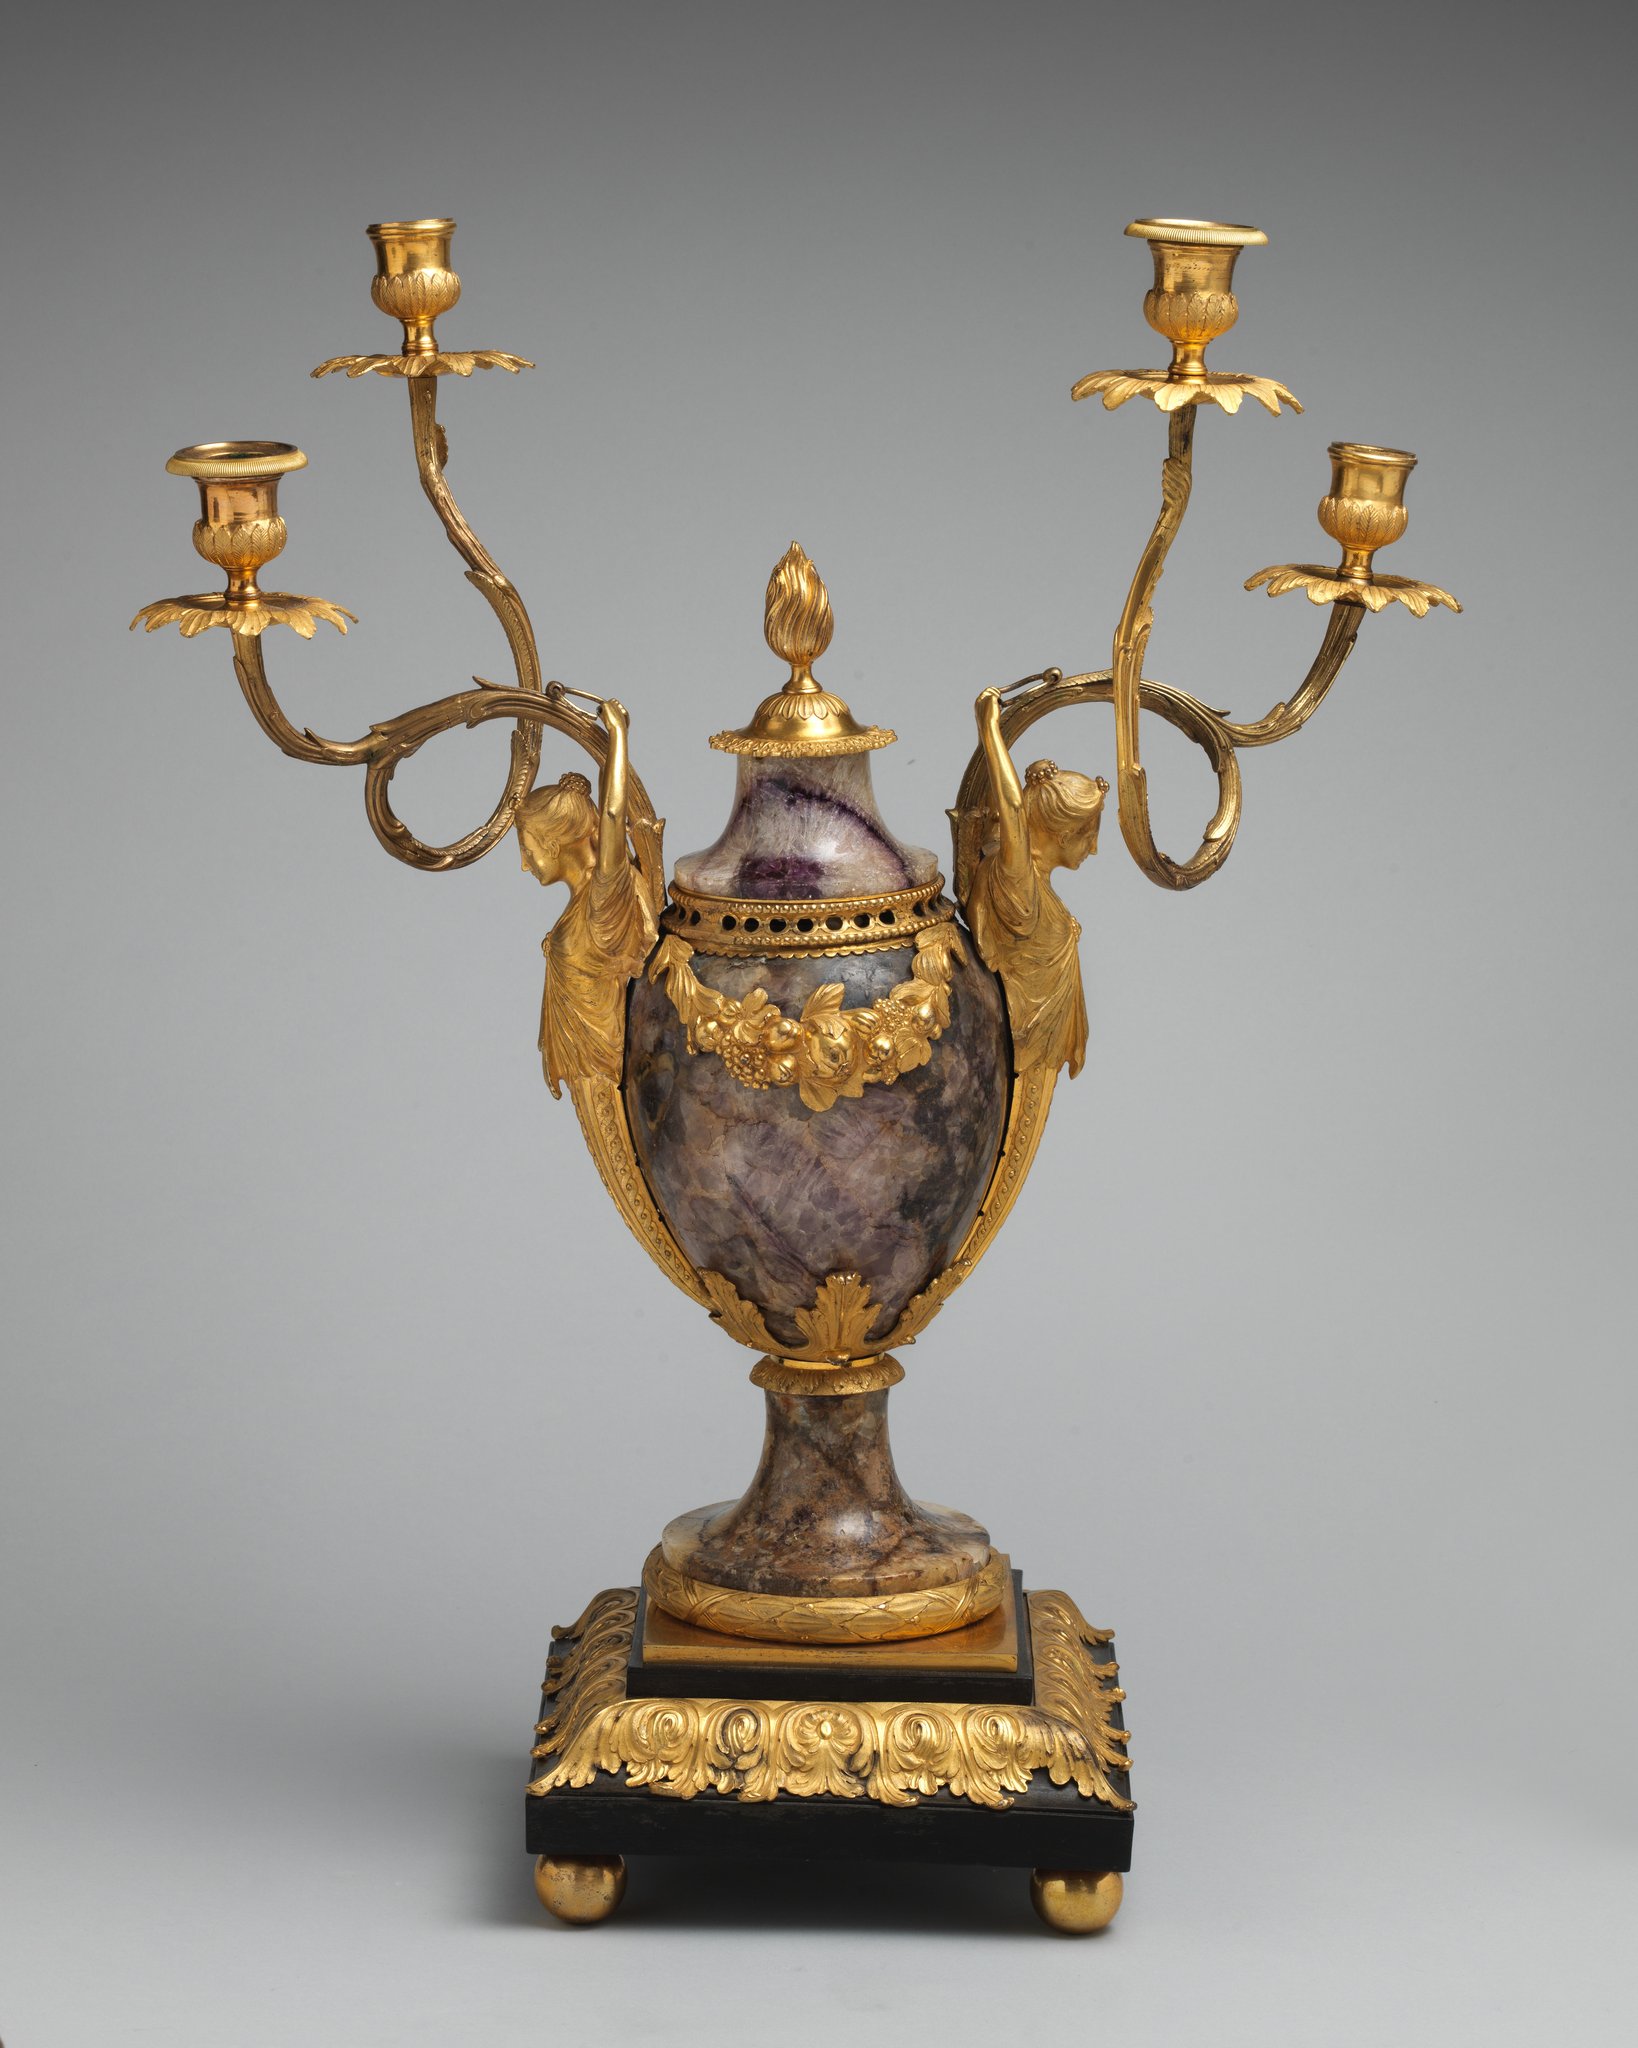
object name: candelabrum perfume burner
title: Candelabrum perfume burner (one of a pair)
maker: matthew boulton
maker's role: maker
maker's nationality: british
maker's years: 1728-1809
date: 1770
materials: bronze, metal, wood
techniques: gilding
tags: caryatids